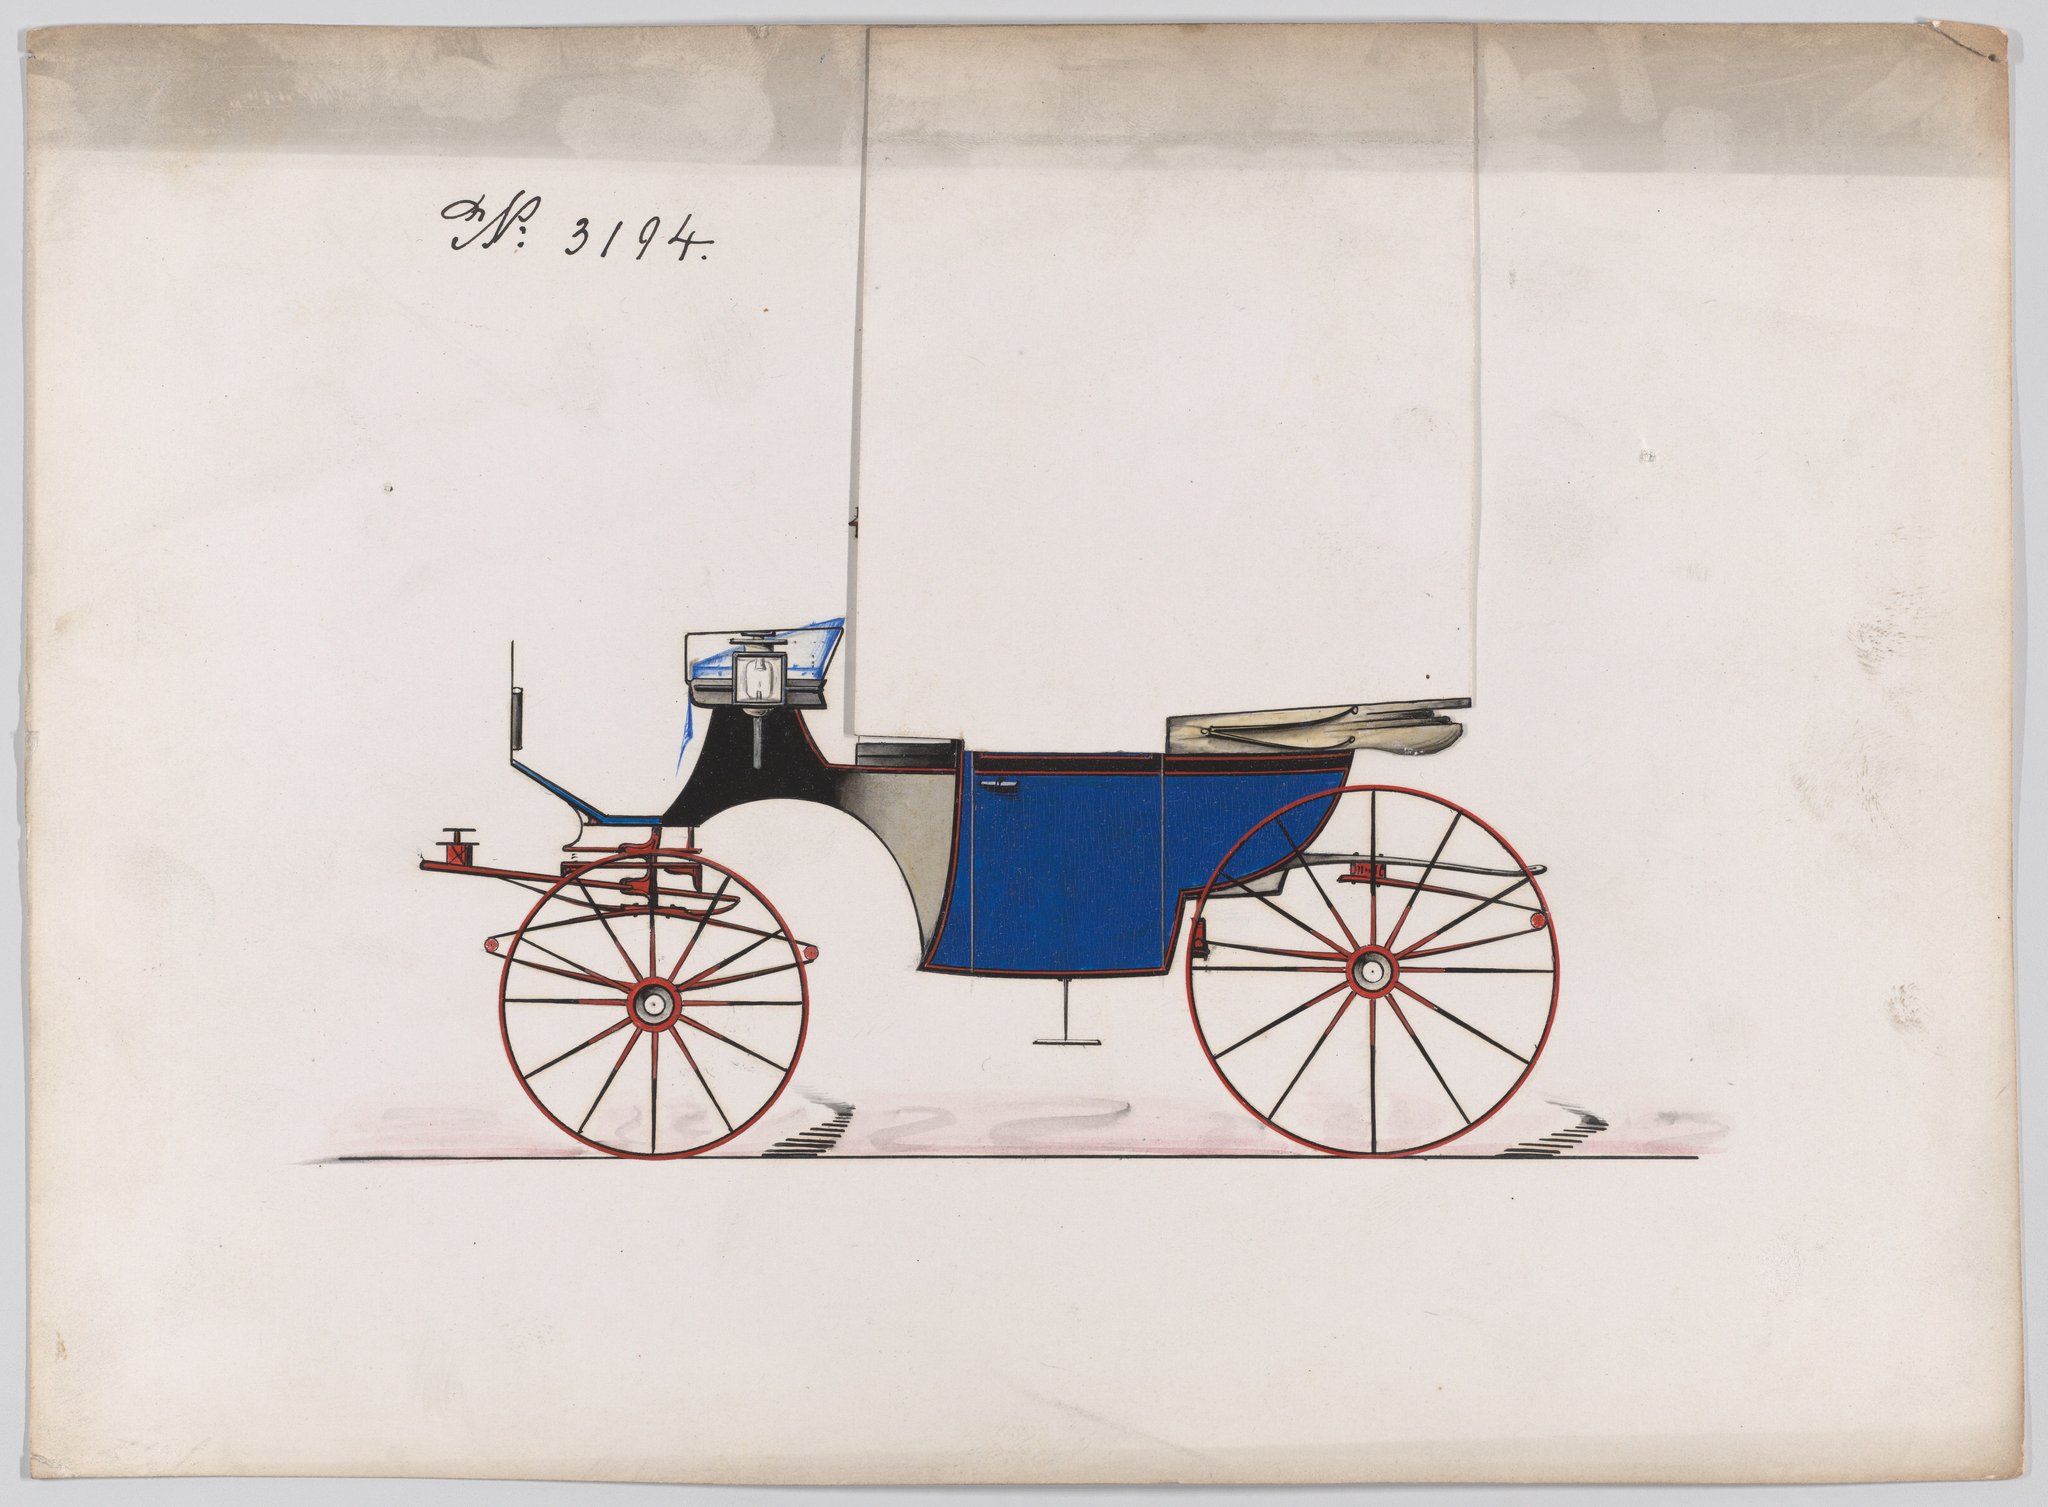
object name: drawing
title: Design for Landaulet, no. 3194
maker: brewster & co.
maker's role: manufacturer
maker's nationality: american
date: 1876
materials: gouache, gum arabic, ink, watercolor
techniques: pen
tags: carriages